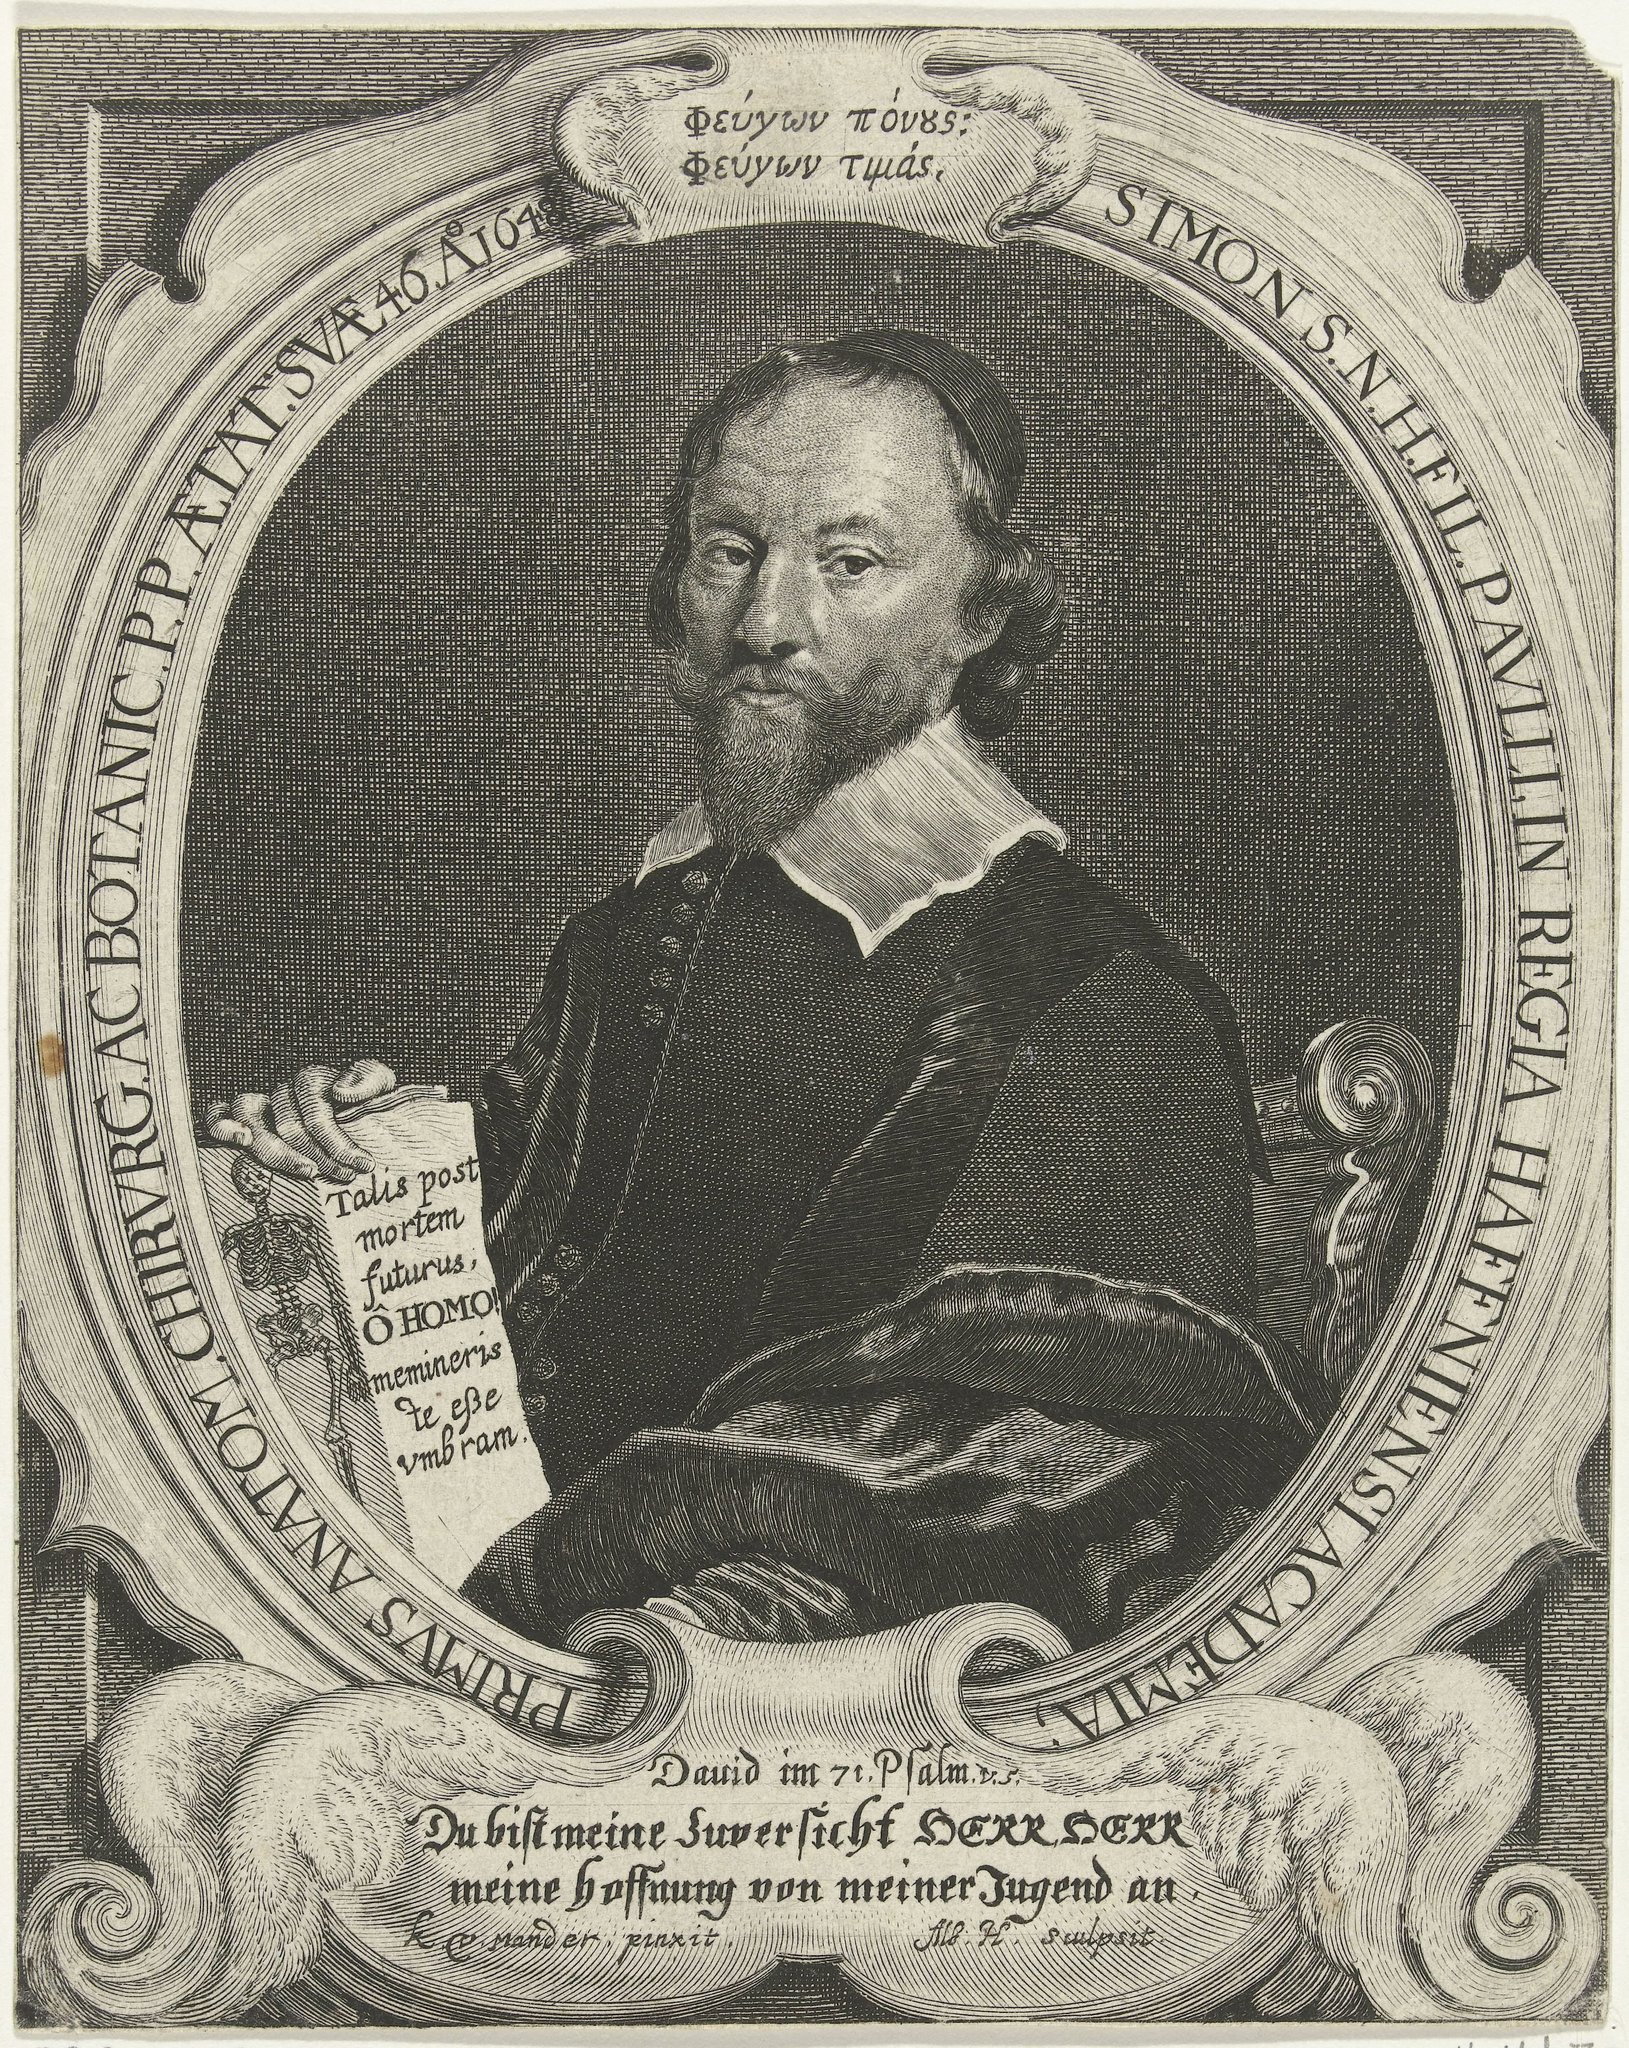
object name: print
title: Portret van Simon Paulli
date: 1648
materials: paper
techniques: engraving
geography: copenhagen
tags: copenhagen (city), moustache, book, beard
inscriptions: collector's mark: Lugt 2228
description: Portret ten halven lijve naar links van Simon Paulli, professor te Kopenhagen, in een ovaal, een boek over anatomie in de hand houdend. Onder zijn portret een cartouche waarin de tekst David im 71. Psalm en de verzen in het Duits. Boven zijn portret twee regels in het Grieks.